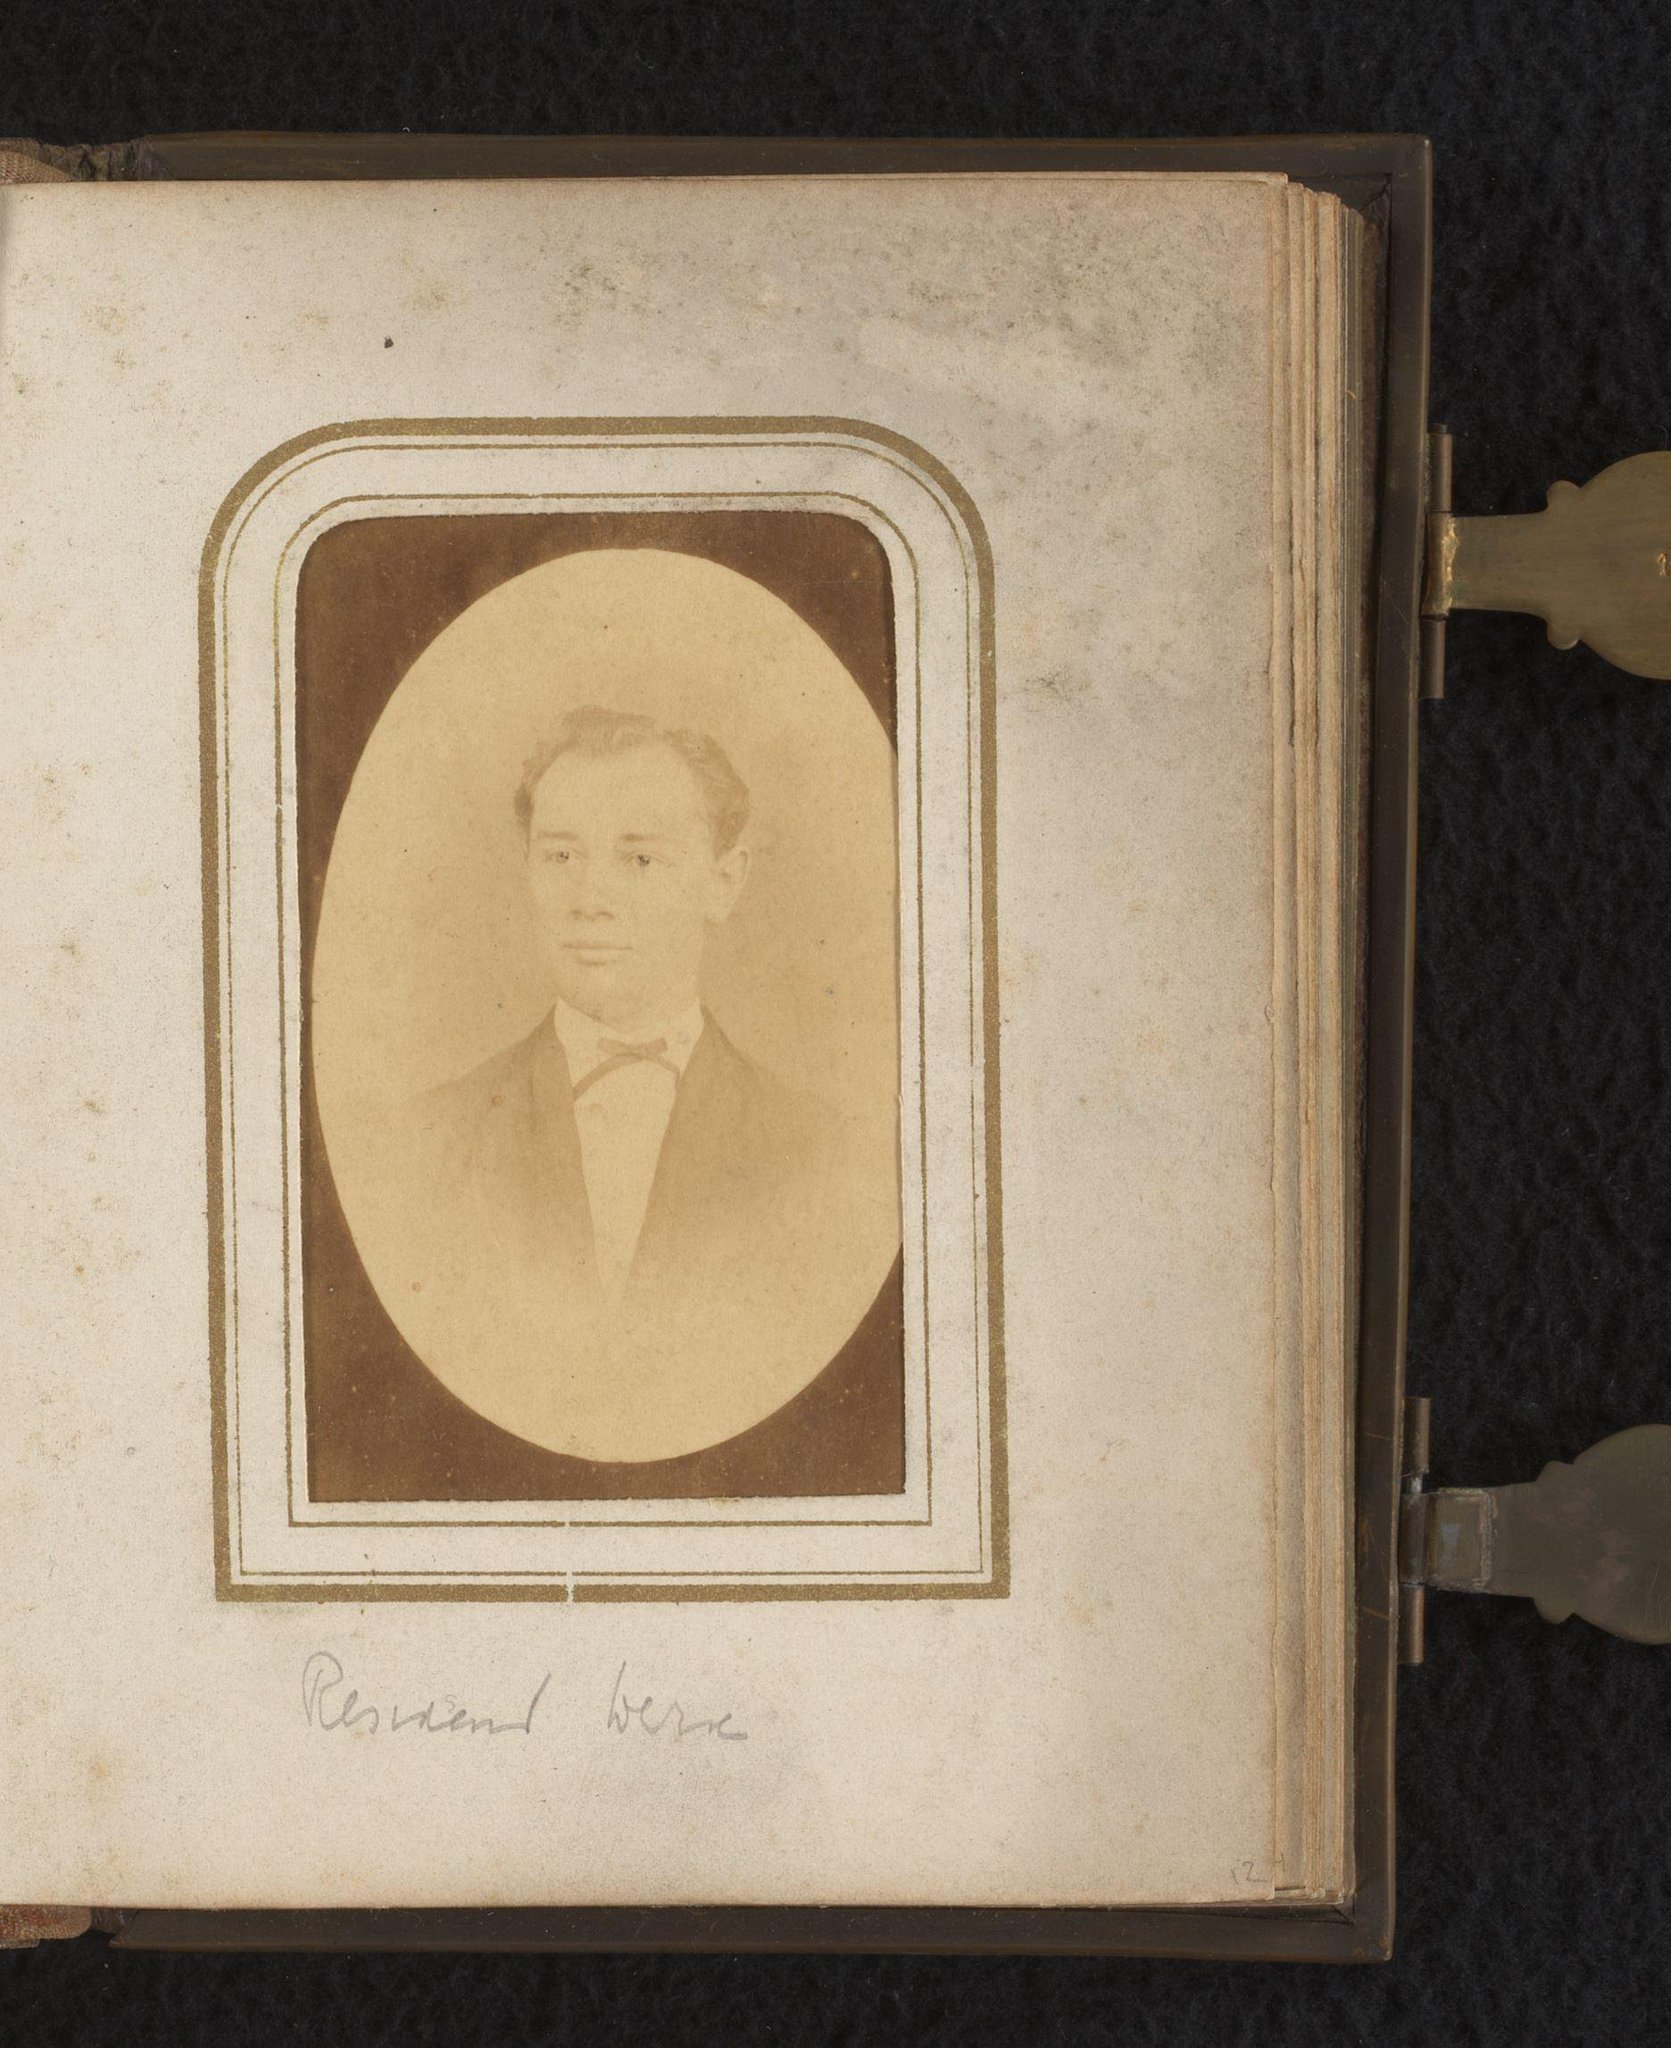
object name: carte de visite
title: Portret van een man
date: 1870-1890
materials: cardboard, photographic support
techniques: albumen print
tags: adult man, historical persons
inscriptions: inscription: ‘Petz & Co./ Photografen/ Batavia’, annotation: ‘[...] [Derz]’, annotation: ‘[...] [Derz]’